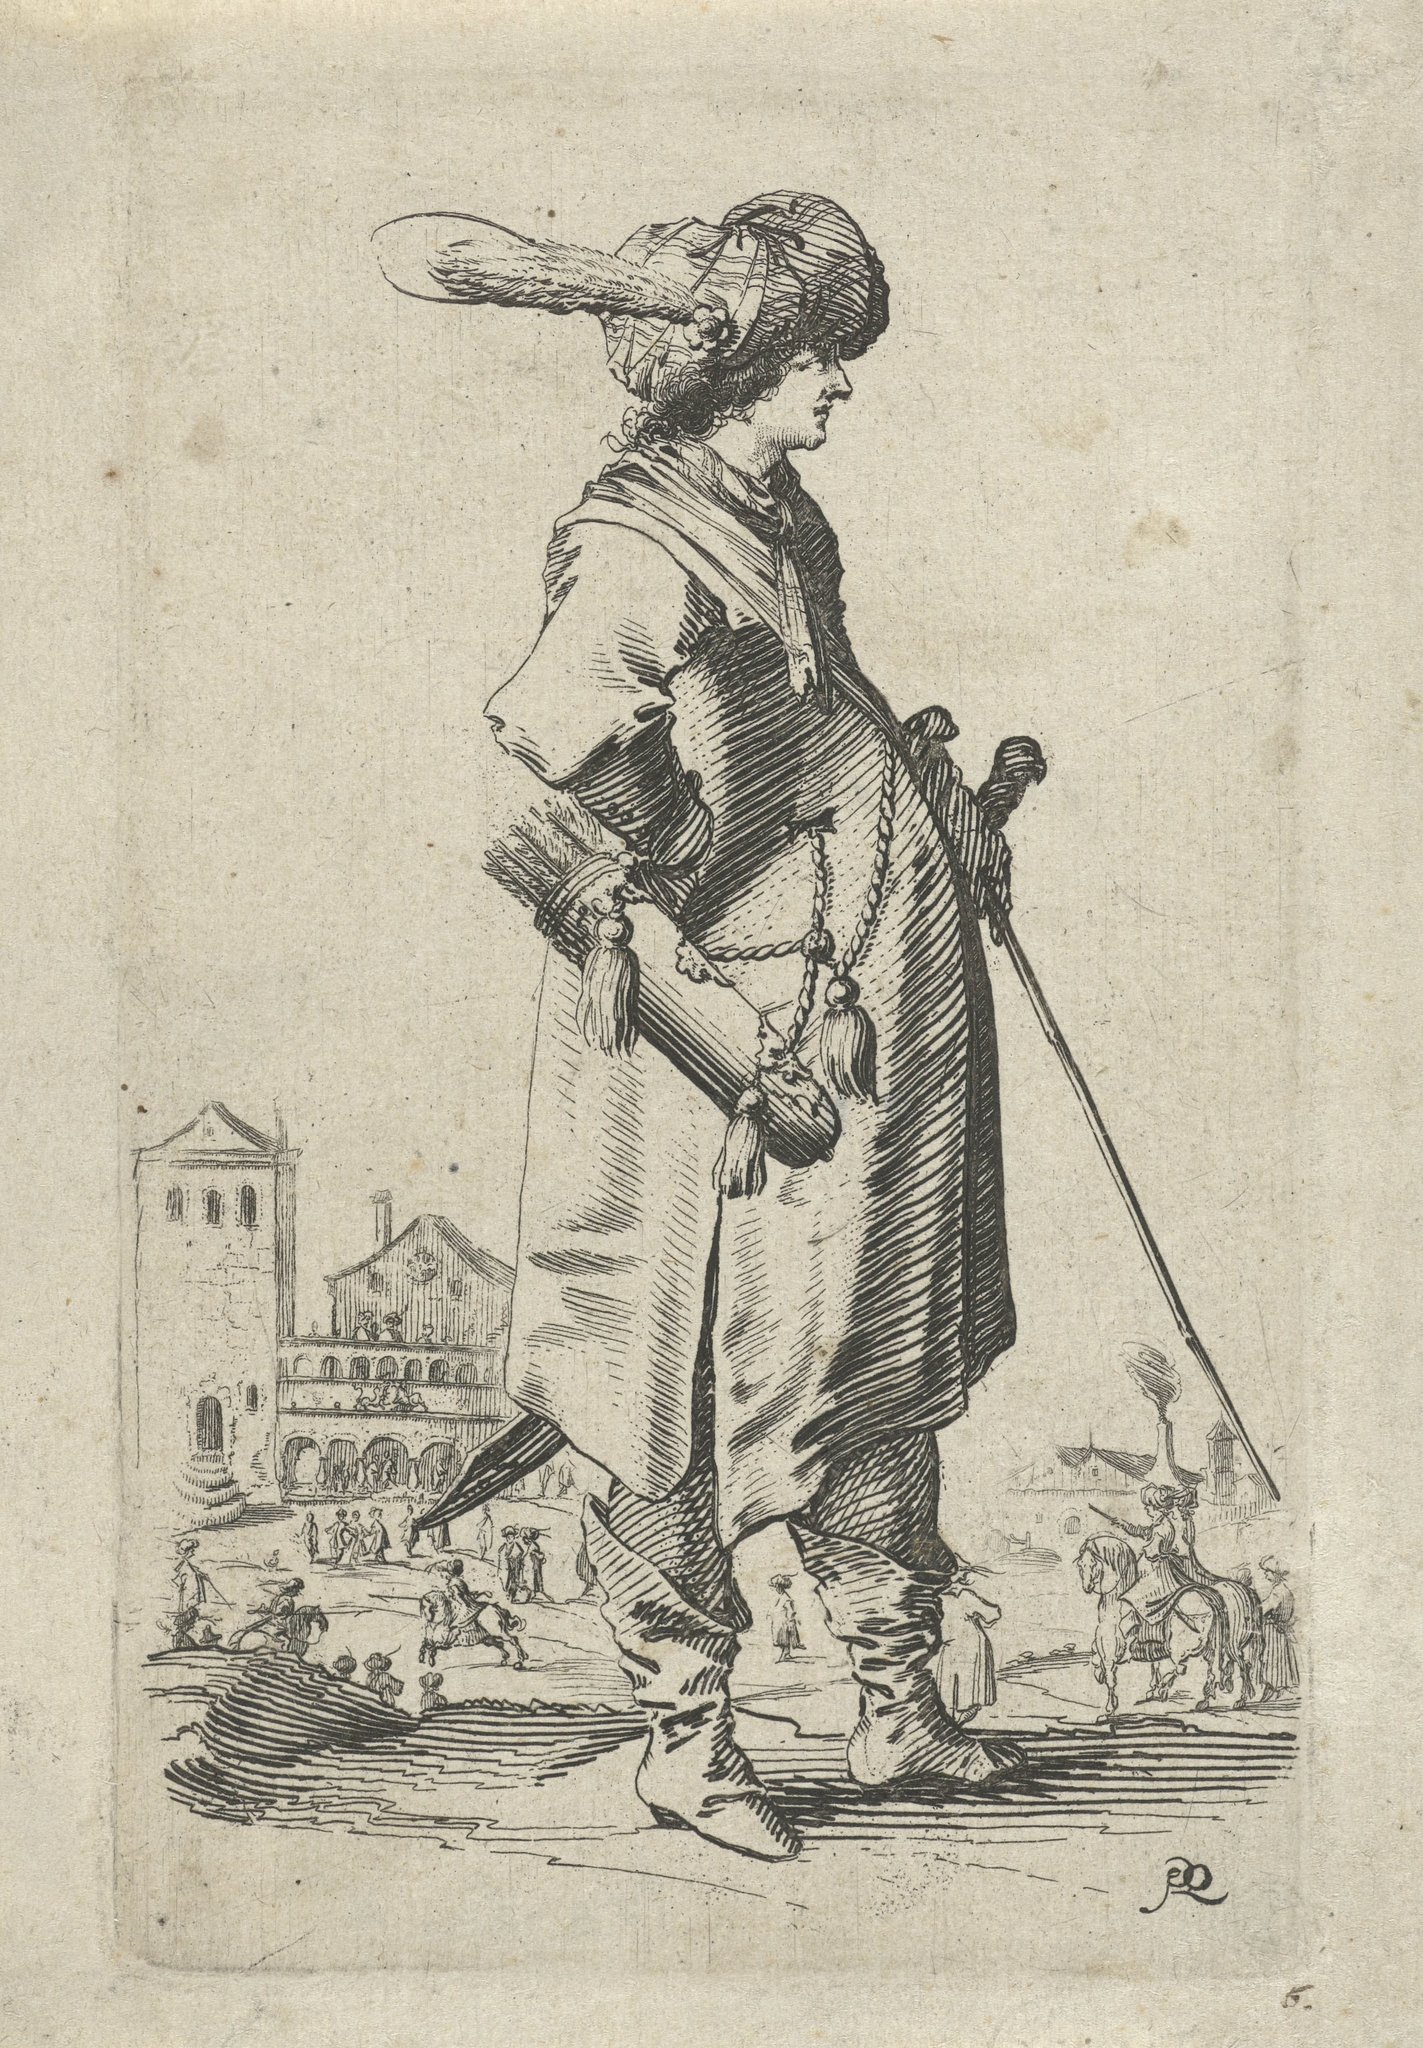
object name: print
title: Turkse officier met pijlkoker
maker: pieter jansz quast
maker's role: draughtsman, painter, print maker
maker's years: 1605-1647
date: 1615-1647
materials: paper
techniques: etching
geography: netherlands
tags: prospect of city, town panorama, silhouette of city - ii - ideal city, asiatic races and peoples: turks, quiver (+ officers), head-gear: turban (+ men's clothes), head-gear: turban (+ feathers used for clothes)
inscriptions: collector's mark: Lugt 2228, collector's mark: Lugt 2233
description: Een Turkse officier, met een tulband op zijn hoofd en met een pijlkoker, staat voor een stad. Op de achtergrond enkele ruiters en voetvolk.